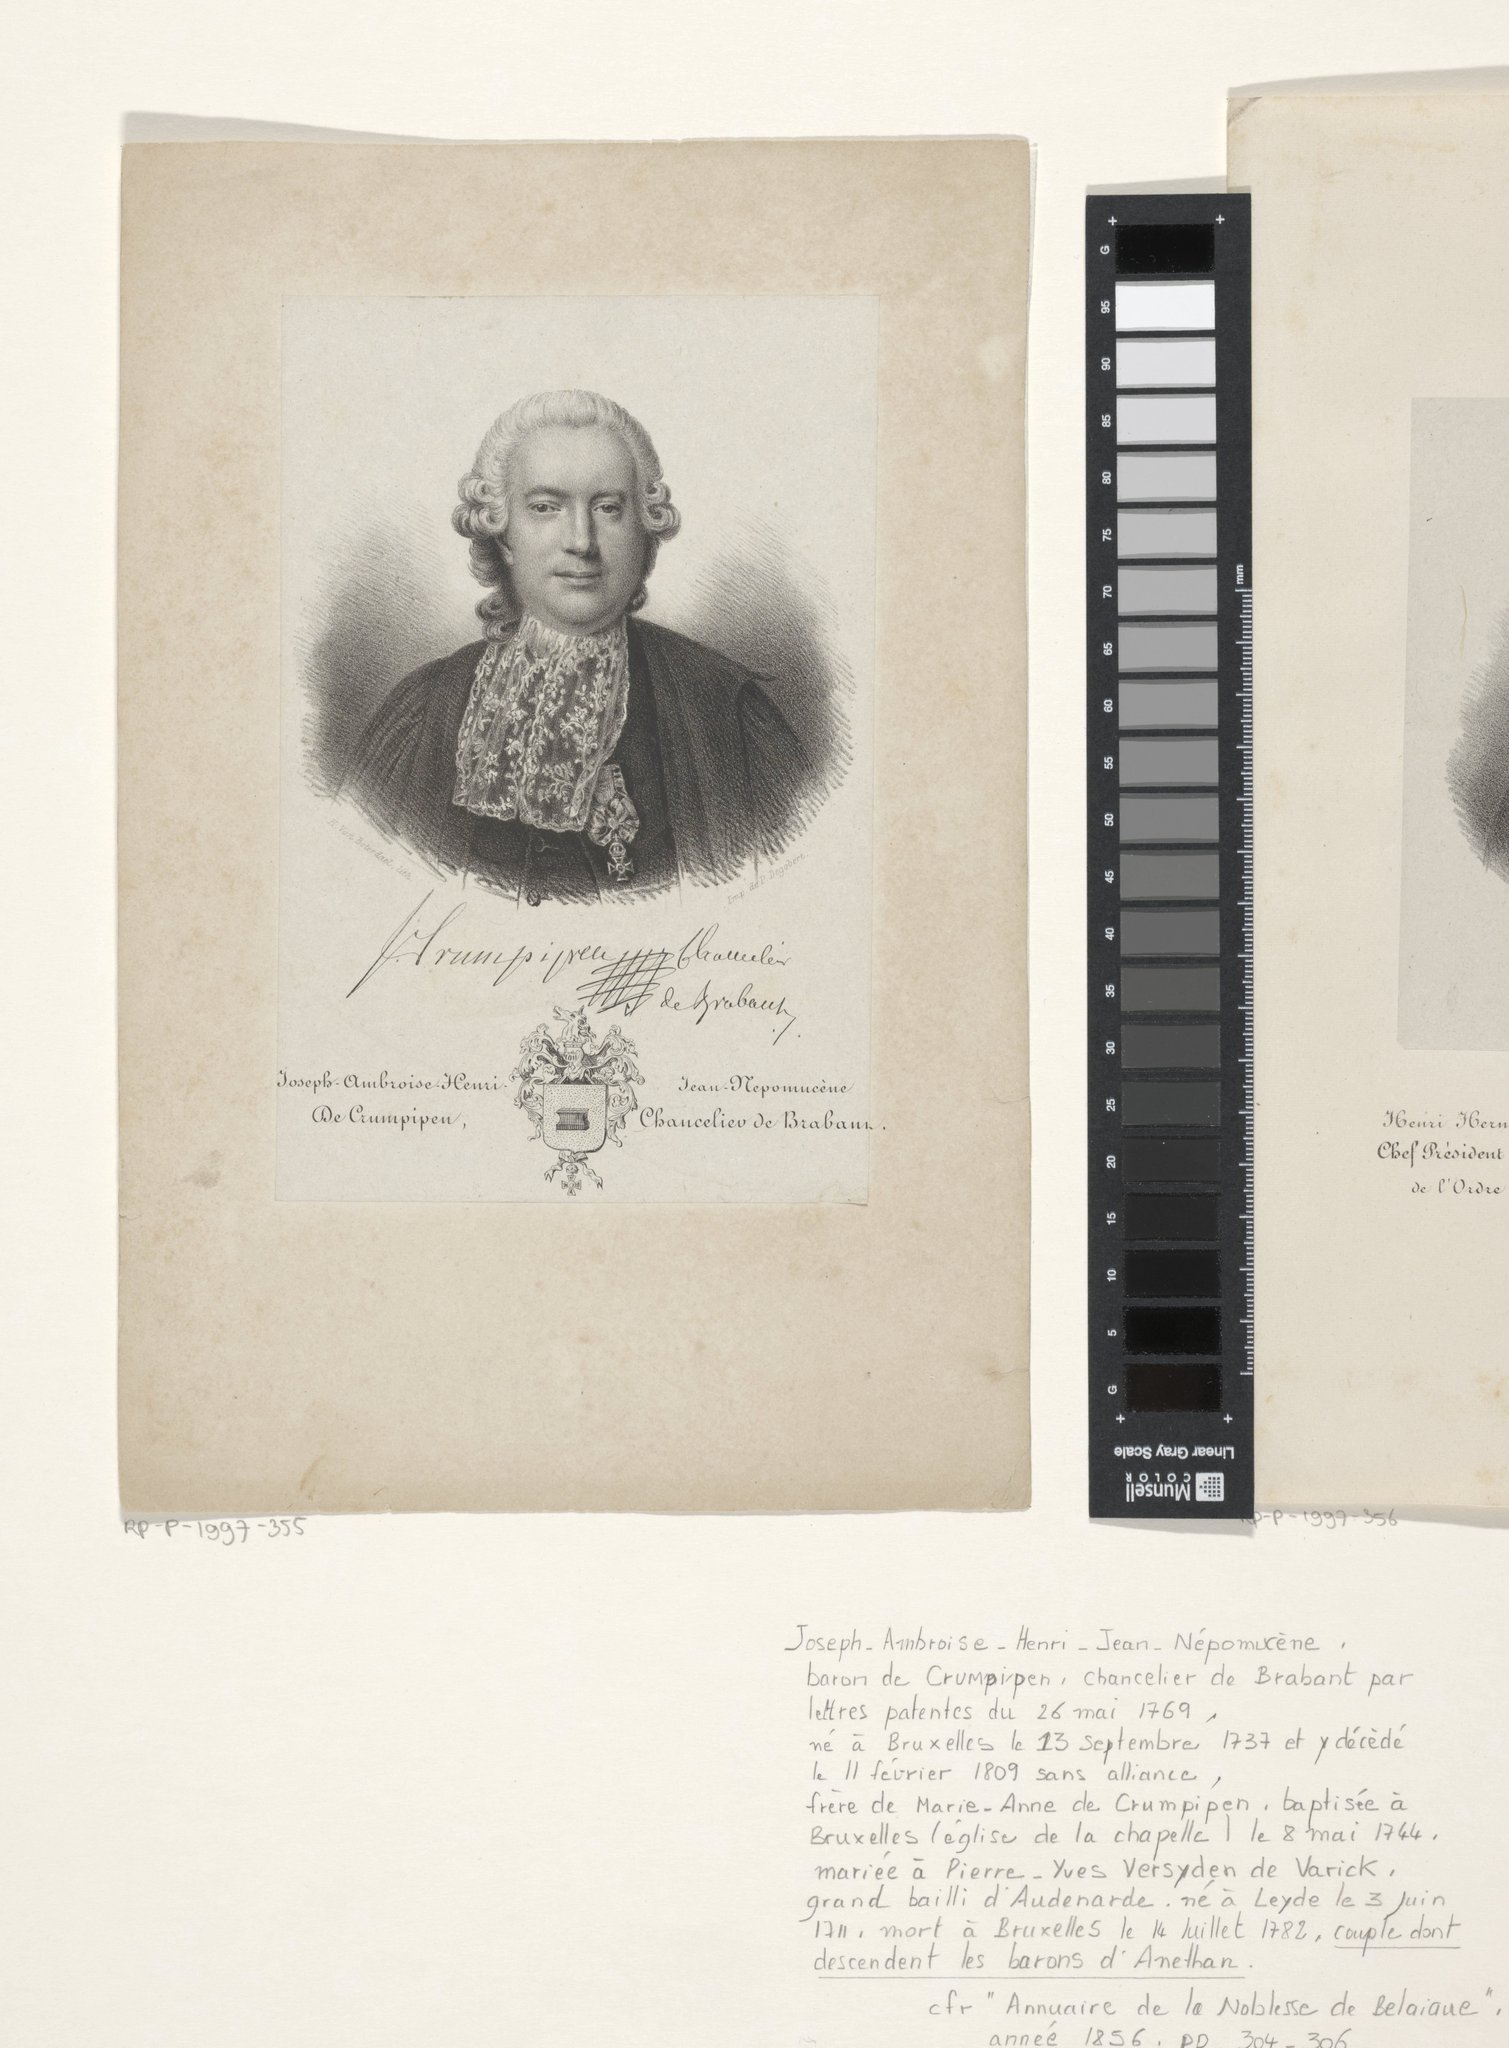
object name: print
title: Portret van Joseph Ambroise de Crumpipen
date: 1830-1840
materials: paper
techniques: lithograph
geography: netherlands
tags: knighthood order, historical persons, wig, armorial bearing, heraldry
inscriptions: collector's mark: Lugt 2228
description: De geportretteerde draagt een pruik en een bef van een doorzichtige stof met bloemmotieven. Op zijn borst draagt hij een ridderorde. Onder het portret zijn signatuur, naam en familiewapen.